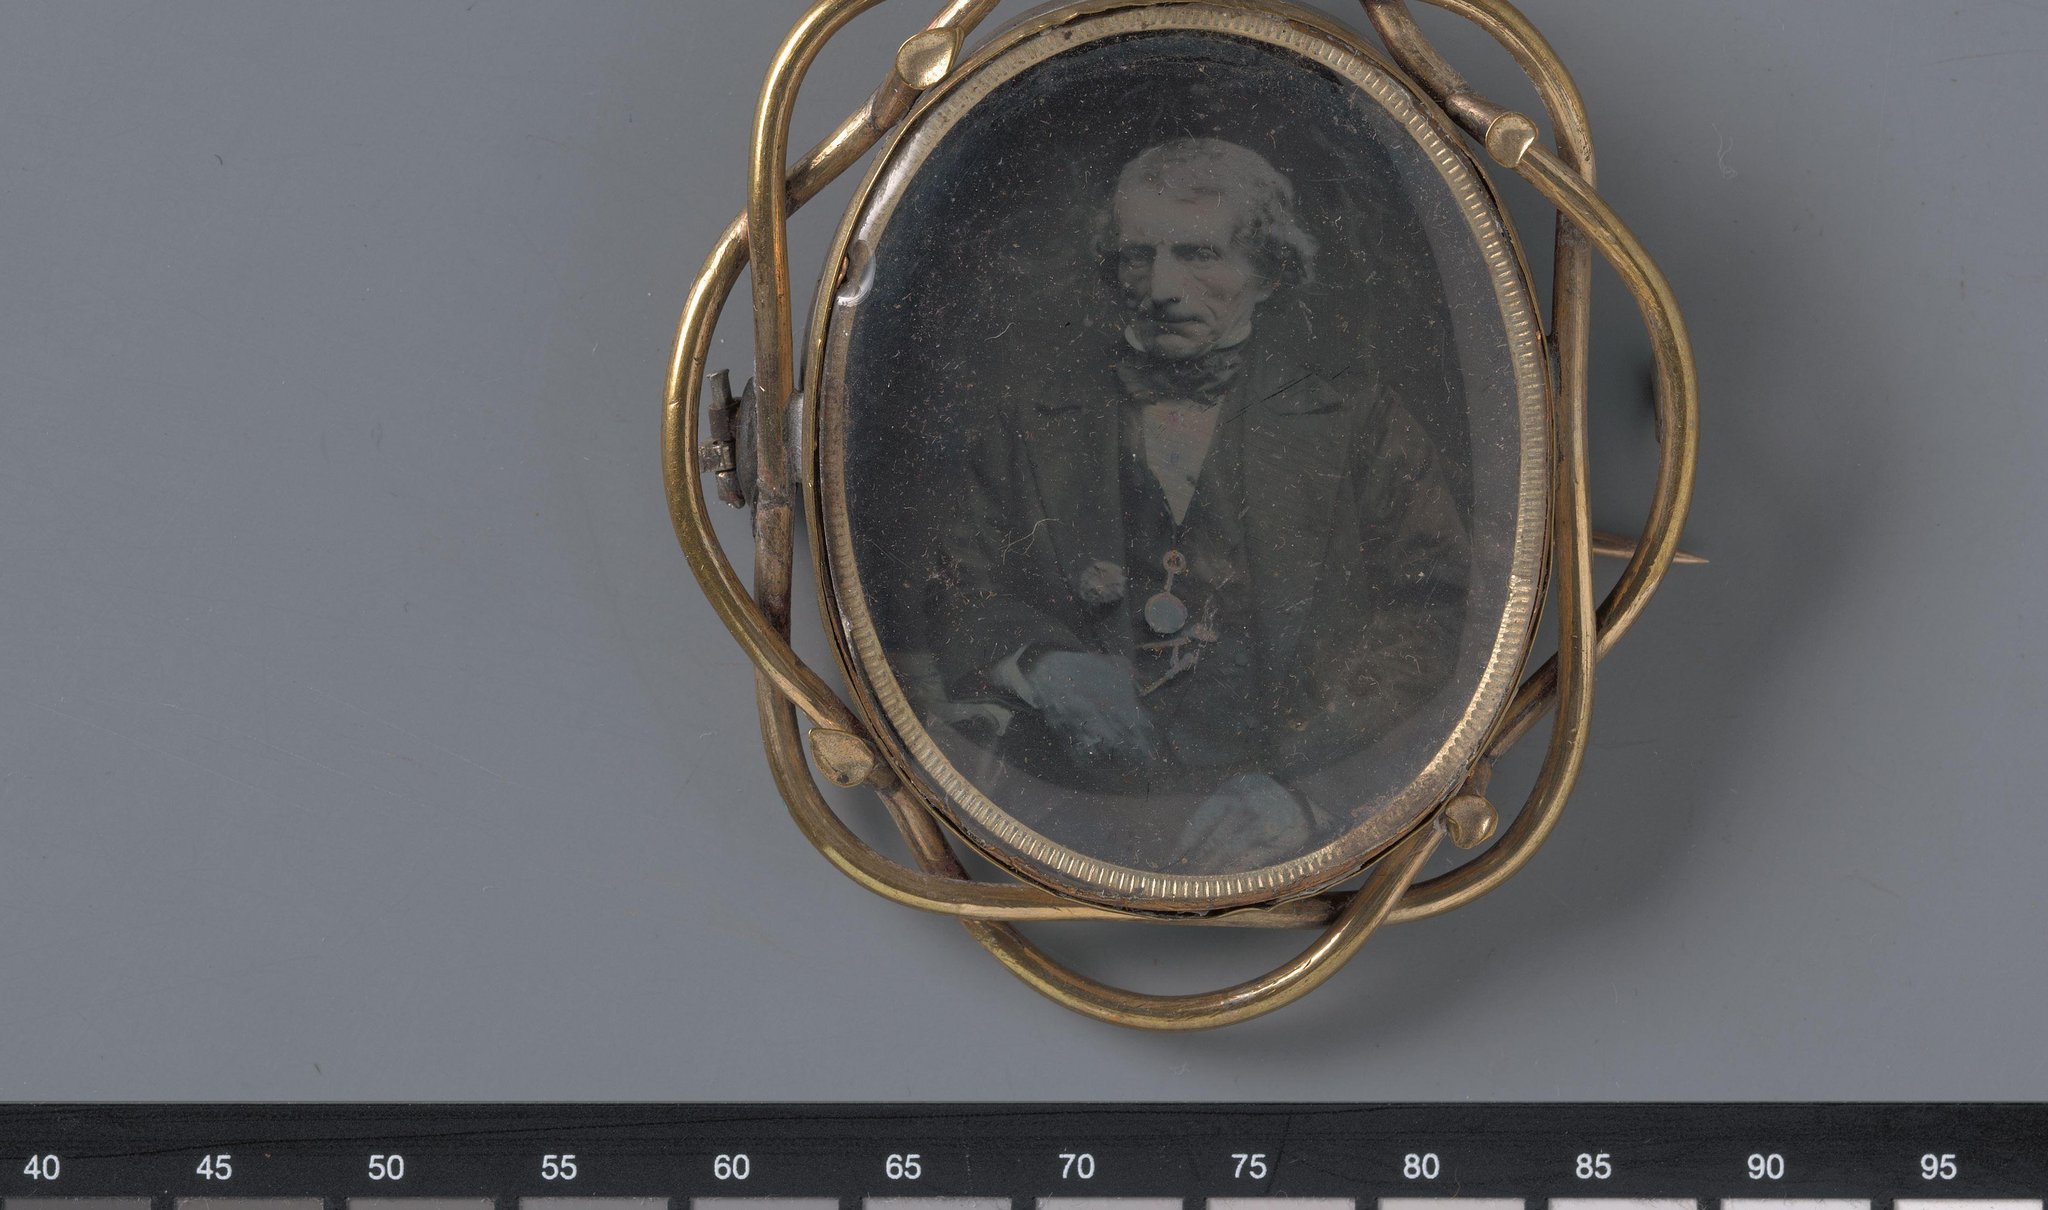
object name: photograph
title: Portret van een zittende onbekende man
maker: Anonymous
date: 1855-1870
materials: glass, metal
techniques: ambrotype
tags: sitting figure, historical persons